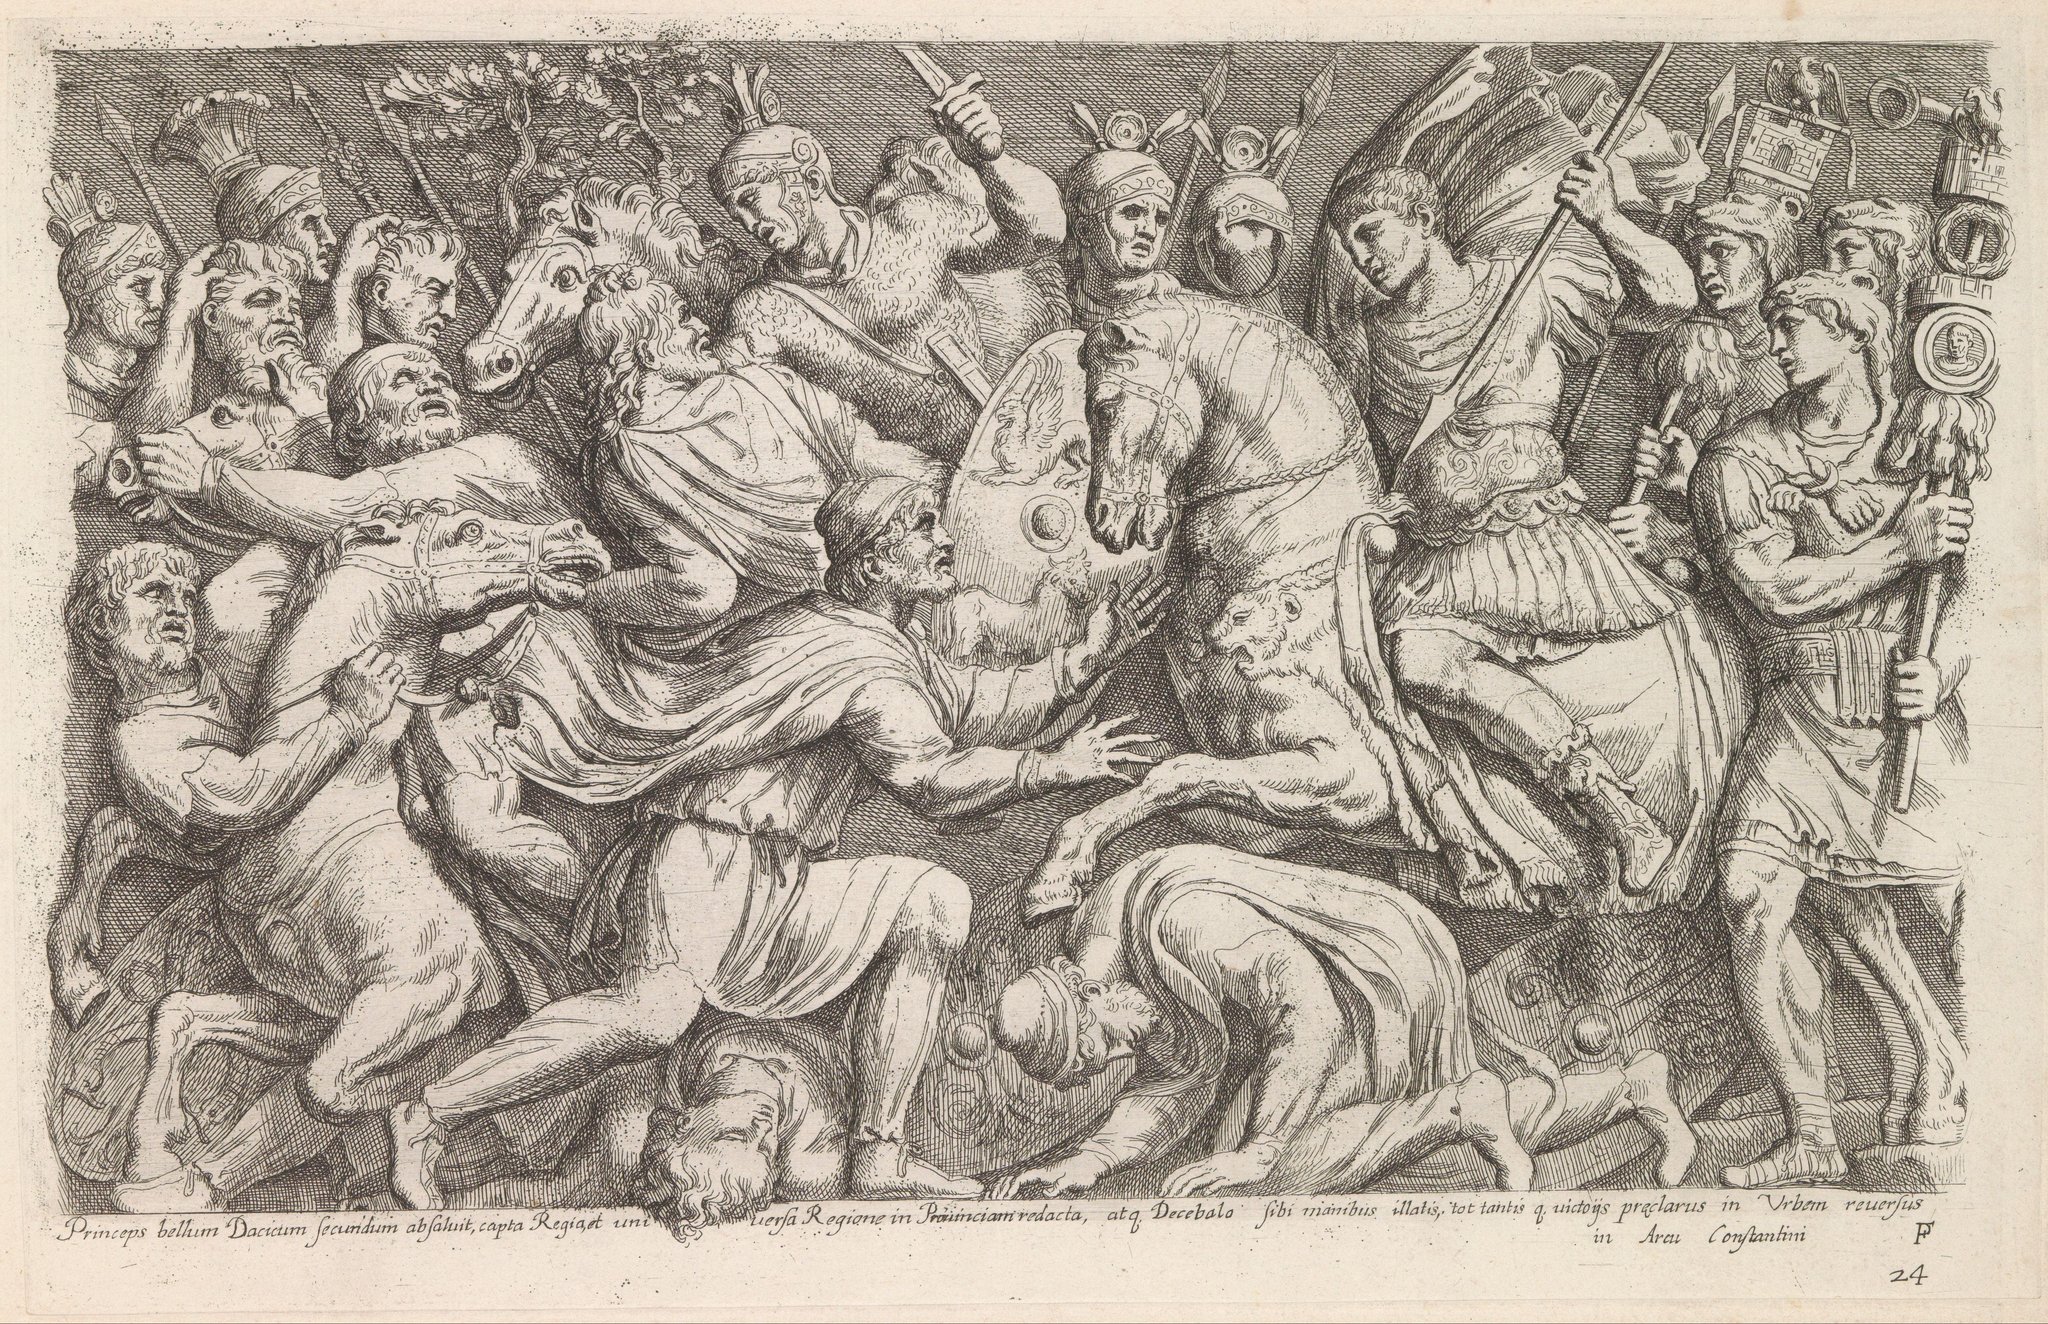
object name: album leaf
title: Romeinse gebeeldhouwde reliëfs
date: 1645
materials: paper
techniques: etching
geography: paris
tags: battle, piece of sculpture, reproduction of a piece of sculpture, the soldier; the soldier's life, the soldier; the soldier's life (+ cavalry, horsemen), arch of constantine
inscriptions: number: ‘51/50’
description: Deze prent maakt deel uit van een reeks van 54 prenten (+ titelprent) naar antieke reliëfs. De nummering op de prenten loopt van 1 tot en met 50. Sommige prenten hebben dubbele nummers. Naar de reliëfs op de Boog van Constantijn te Rome.